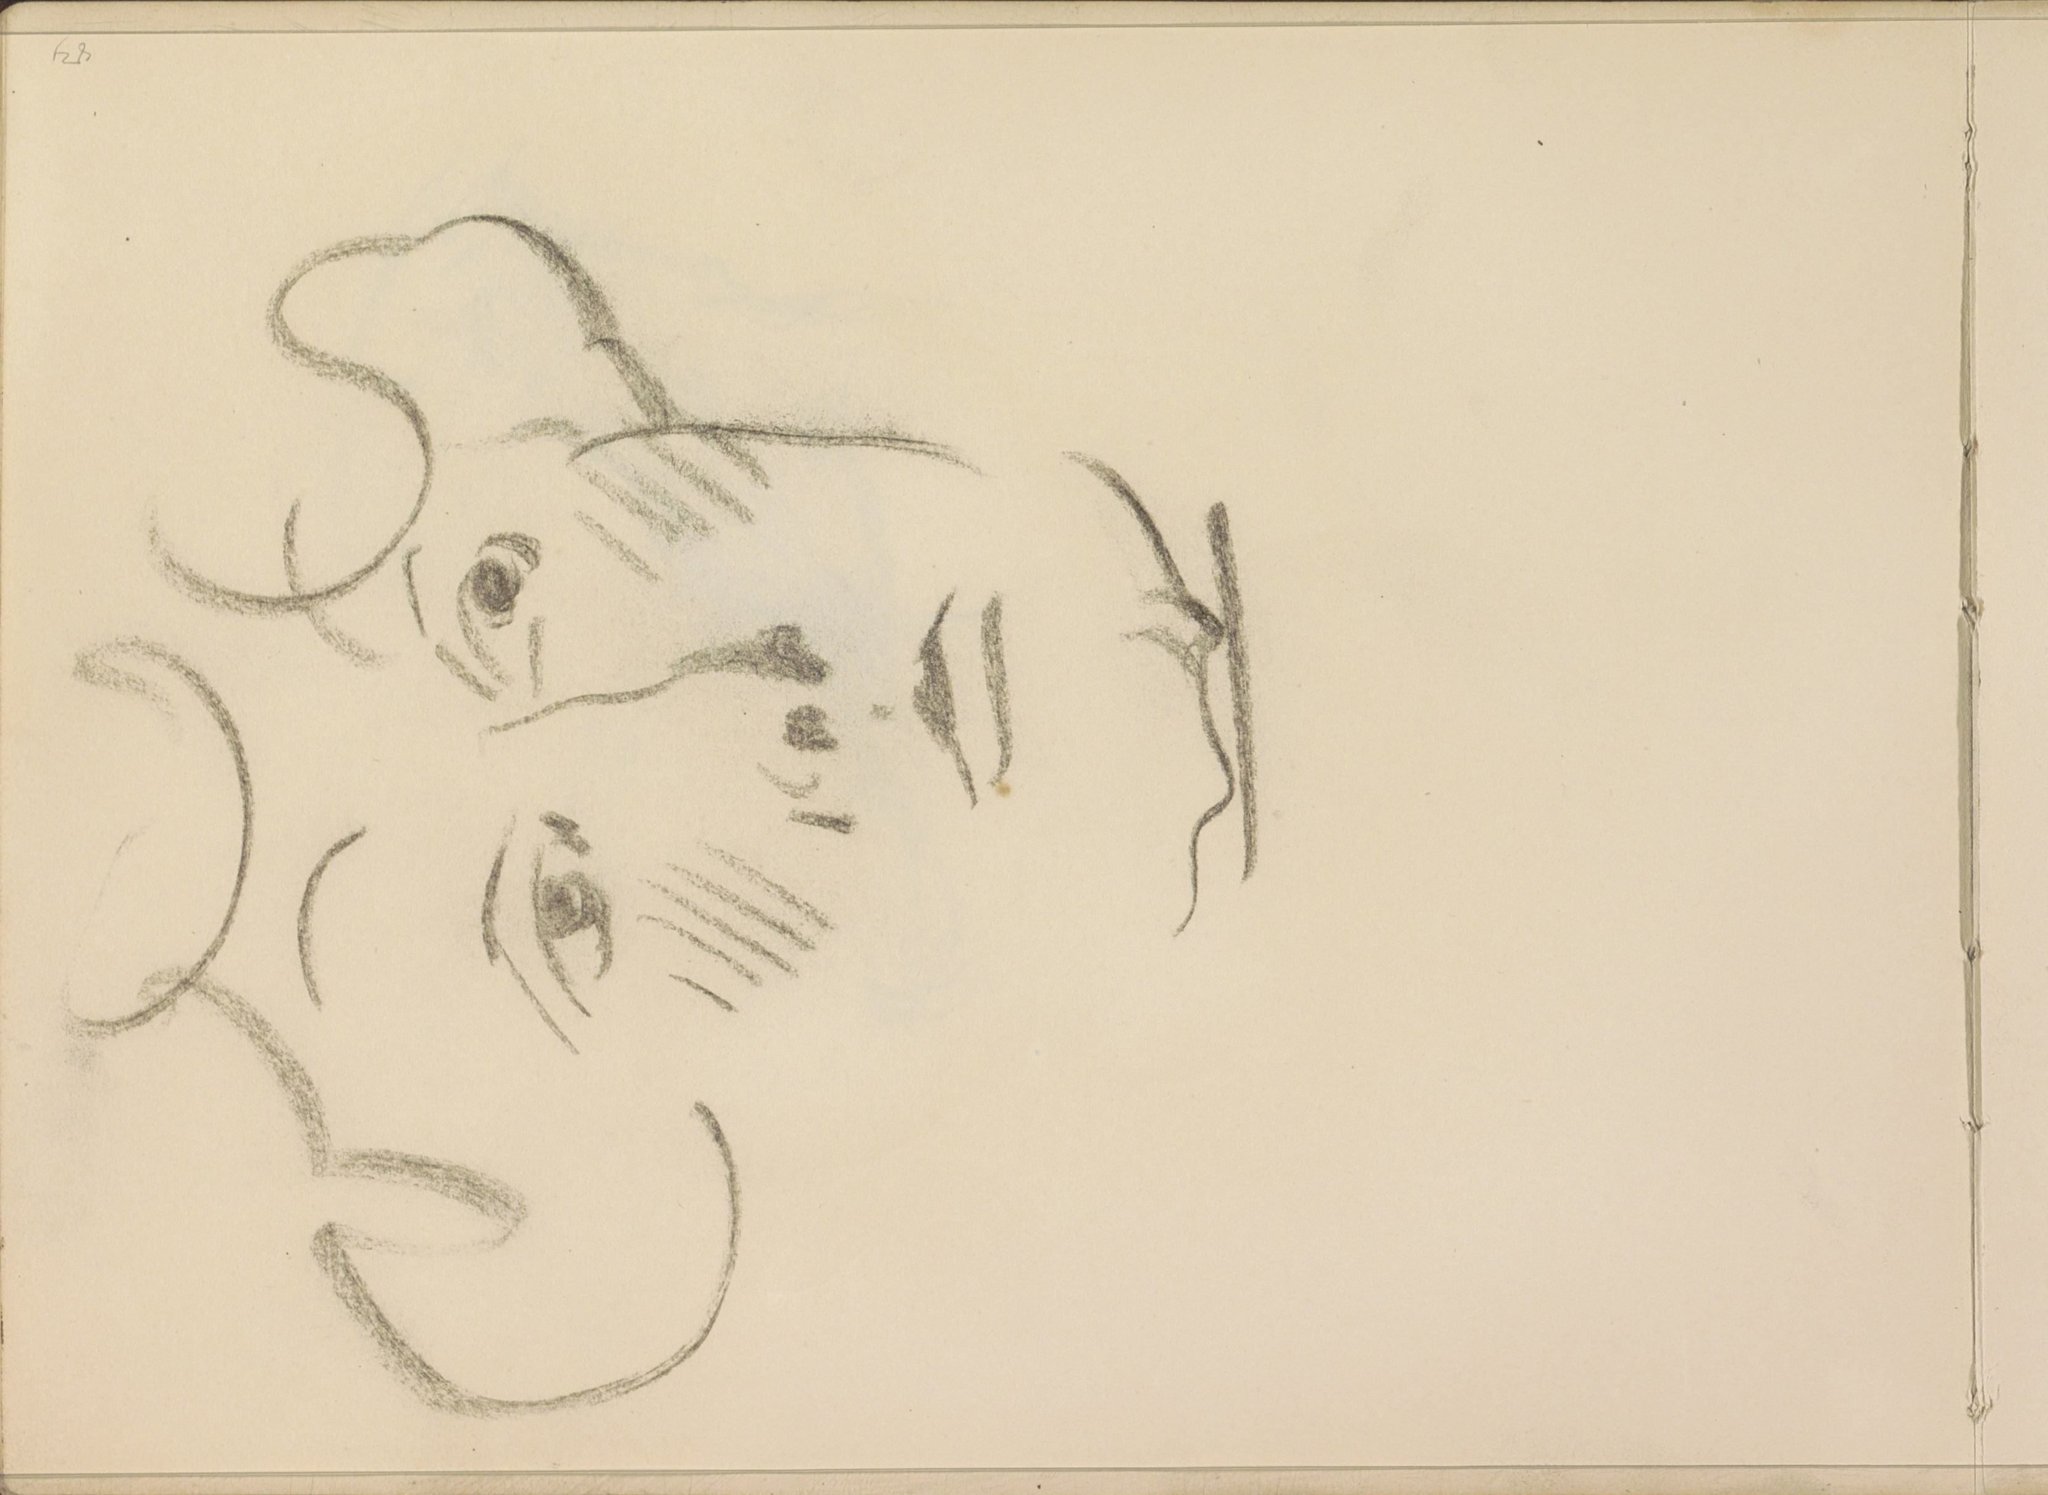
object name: sketchbook leaf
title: Gezicht van een vrouw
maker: isaac israels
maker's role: draughtsman, painter, print maker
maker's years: 1865-1934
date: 1890-1920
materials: chalk, paper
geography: the hague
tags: face (+ female (human being) (not to be used where -aa- is prescribed))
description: Blad 3 verso uit schetsboek X met 43 bladen.